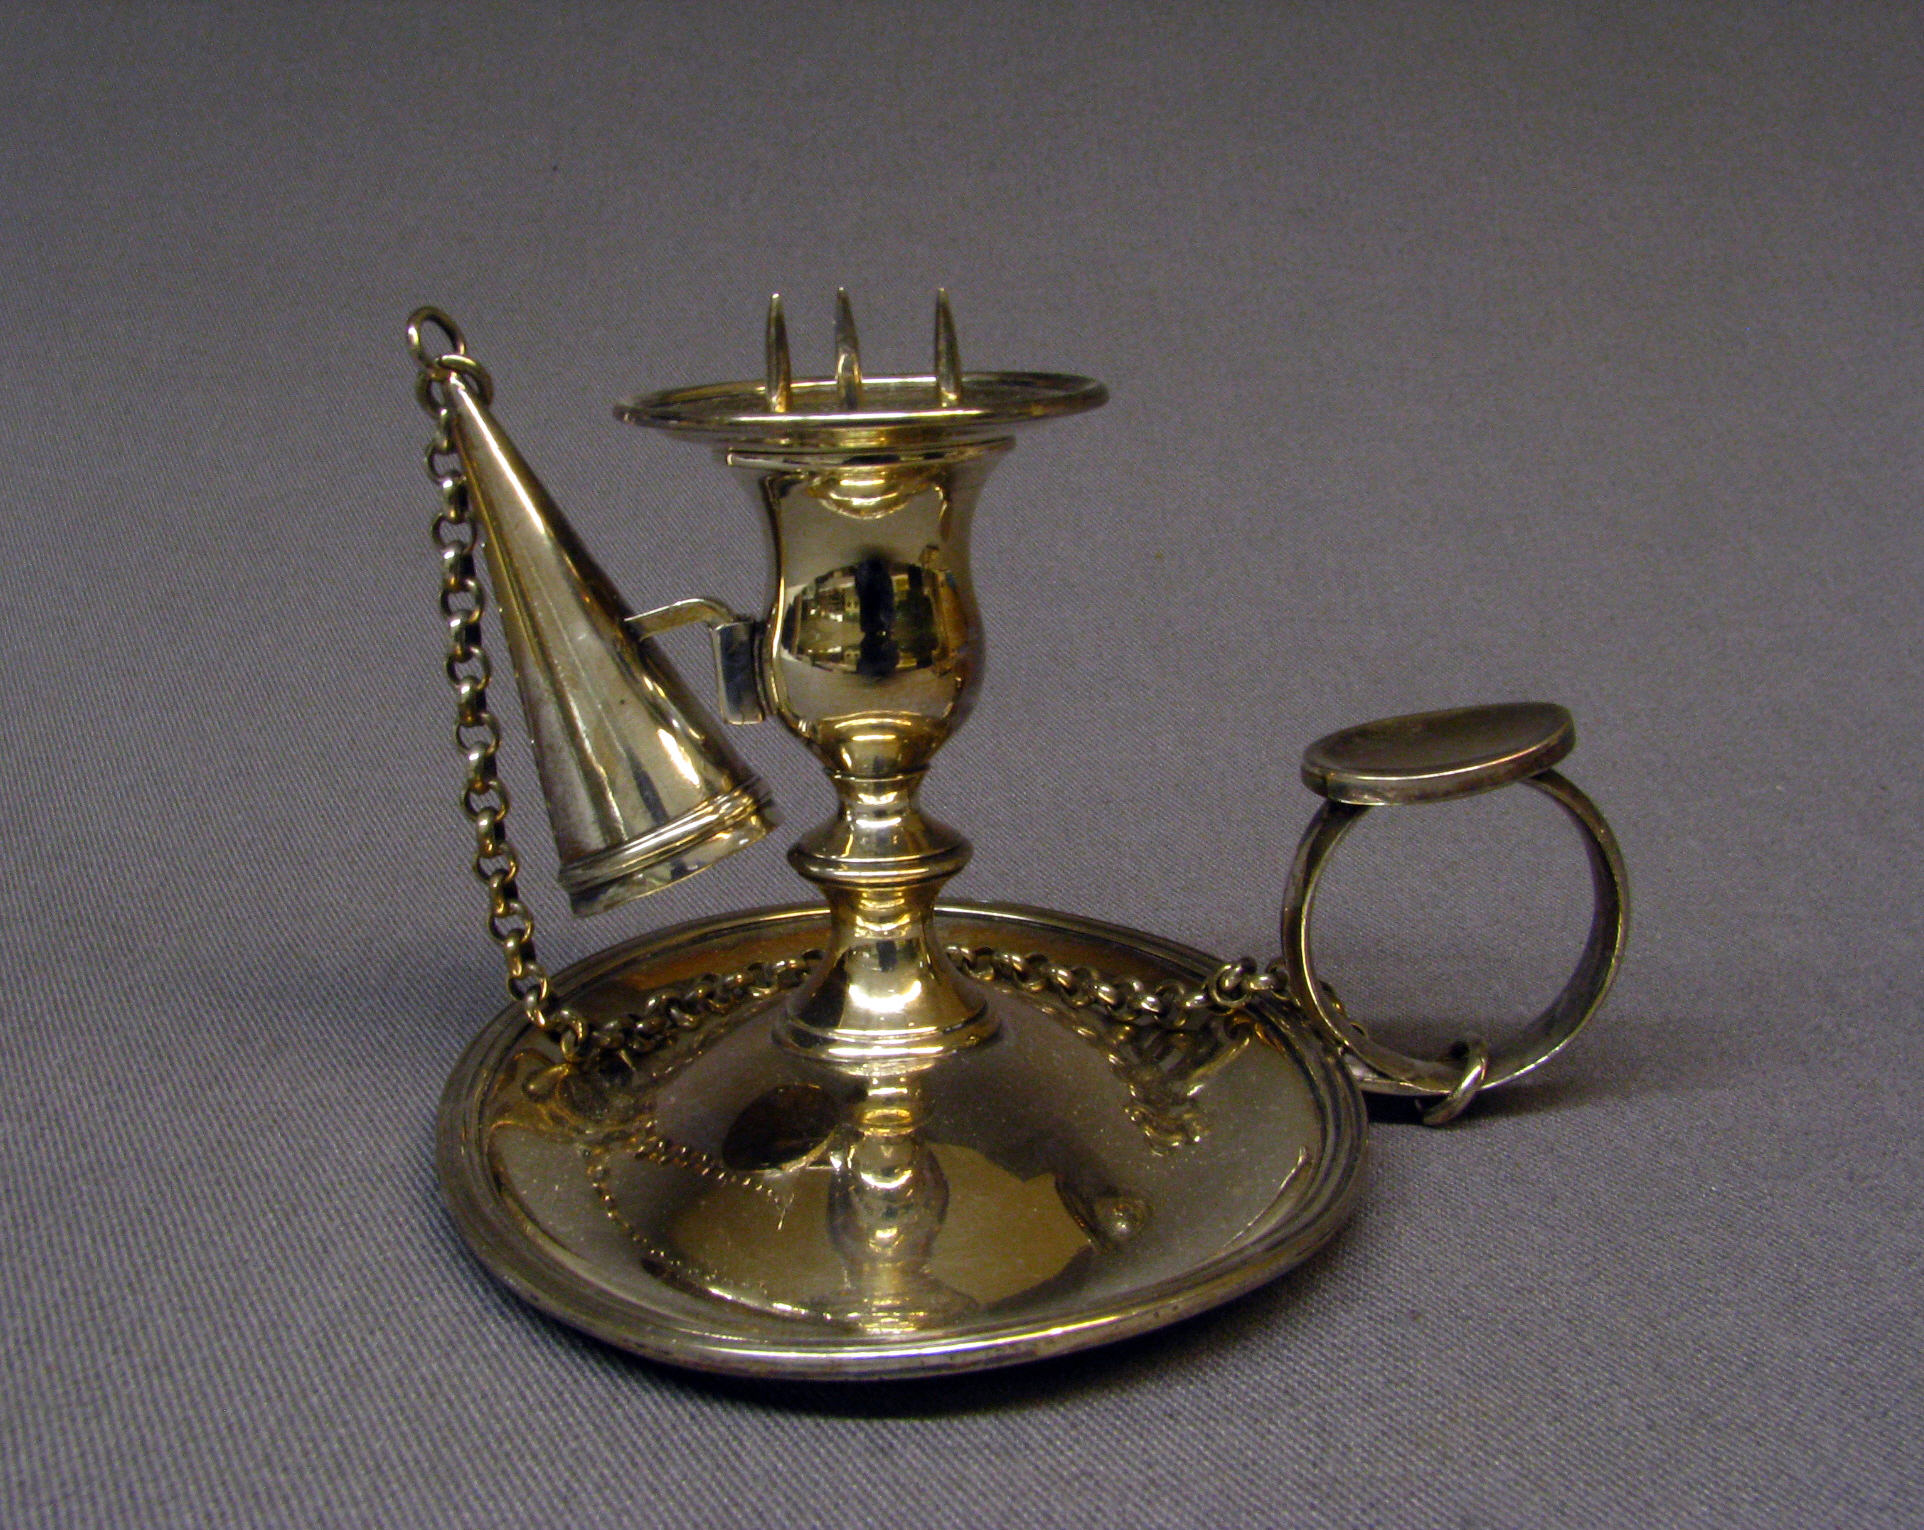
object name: chamber candlestick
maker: john mcdonald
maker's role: maker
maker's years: 1800-1825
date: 1810-1820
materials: silver